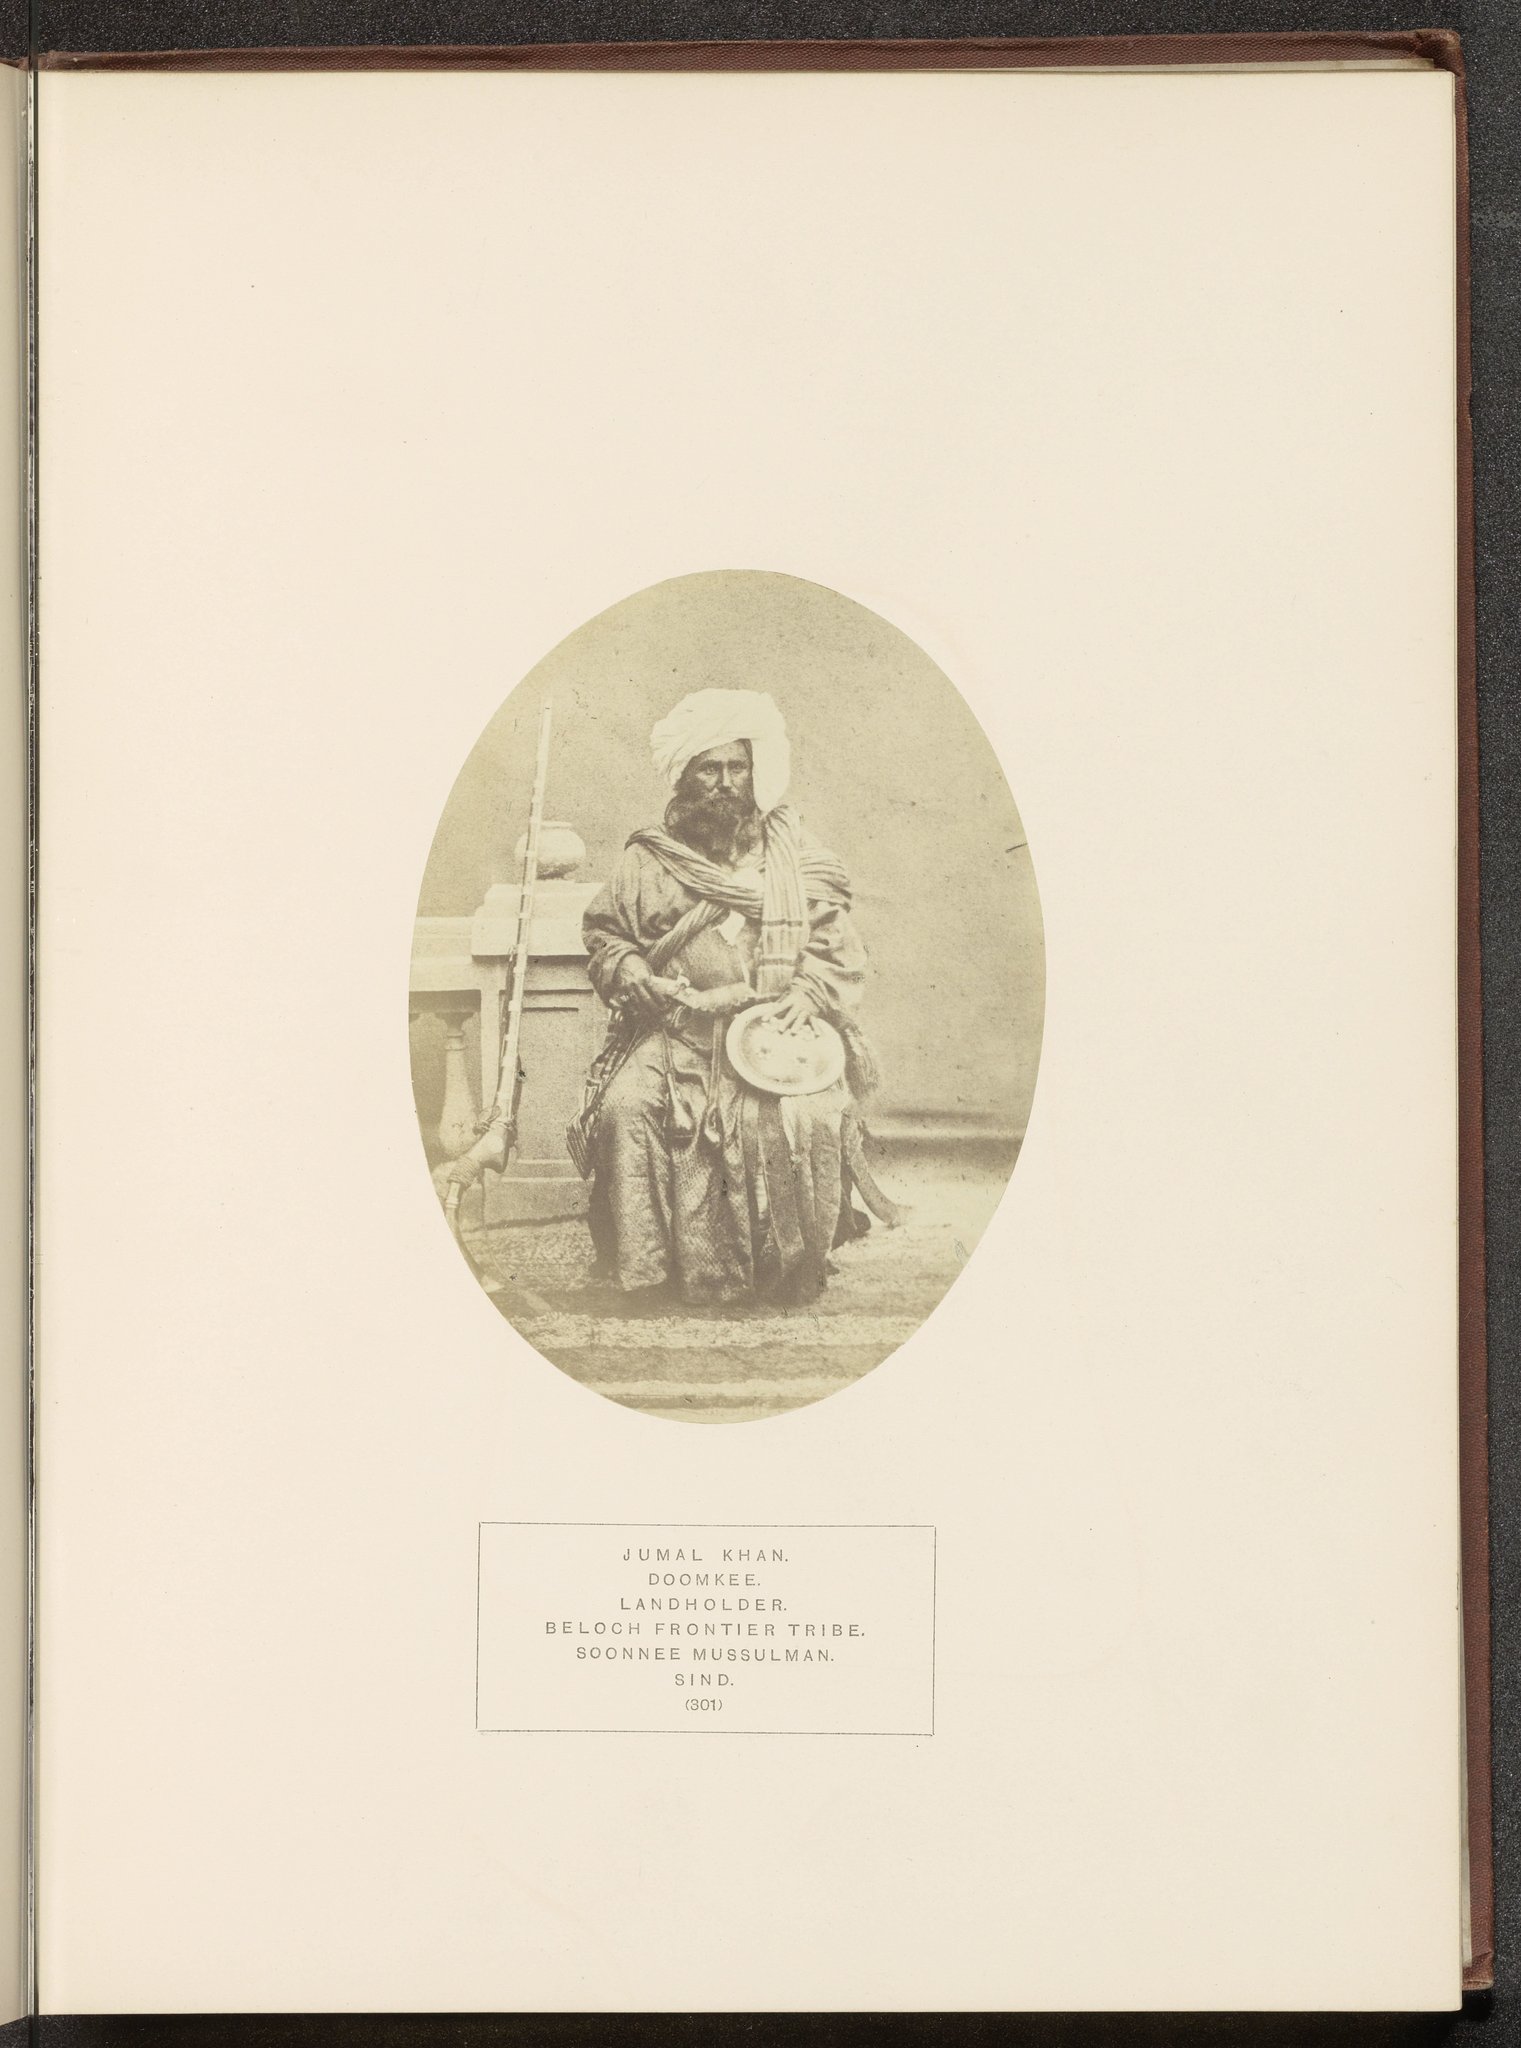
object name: photograph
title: Portrait of Jamul Khan, a chief of the Domki Baloch tribe in Sindh, Pakistan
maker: henry charles baskerville tanner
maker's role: fotograaf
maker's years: 1835-1898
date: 1862-1872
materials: photographic support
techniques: albumen print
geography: sindh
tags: head-gear: turban, firearms: rifle, ruler, sovereign, human races; peoples; nationalities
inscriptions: number: ‘(301)’, inscription: ‘JUMAL KHAN./ DOOMKEE./ LANDHOLDER./ BELOCH FRONTIER TRIBE./ SOONNEE MUSSULMAN./ SIND.’